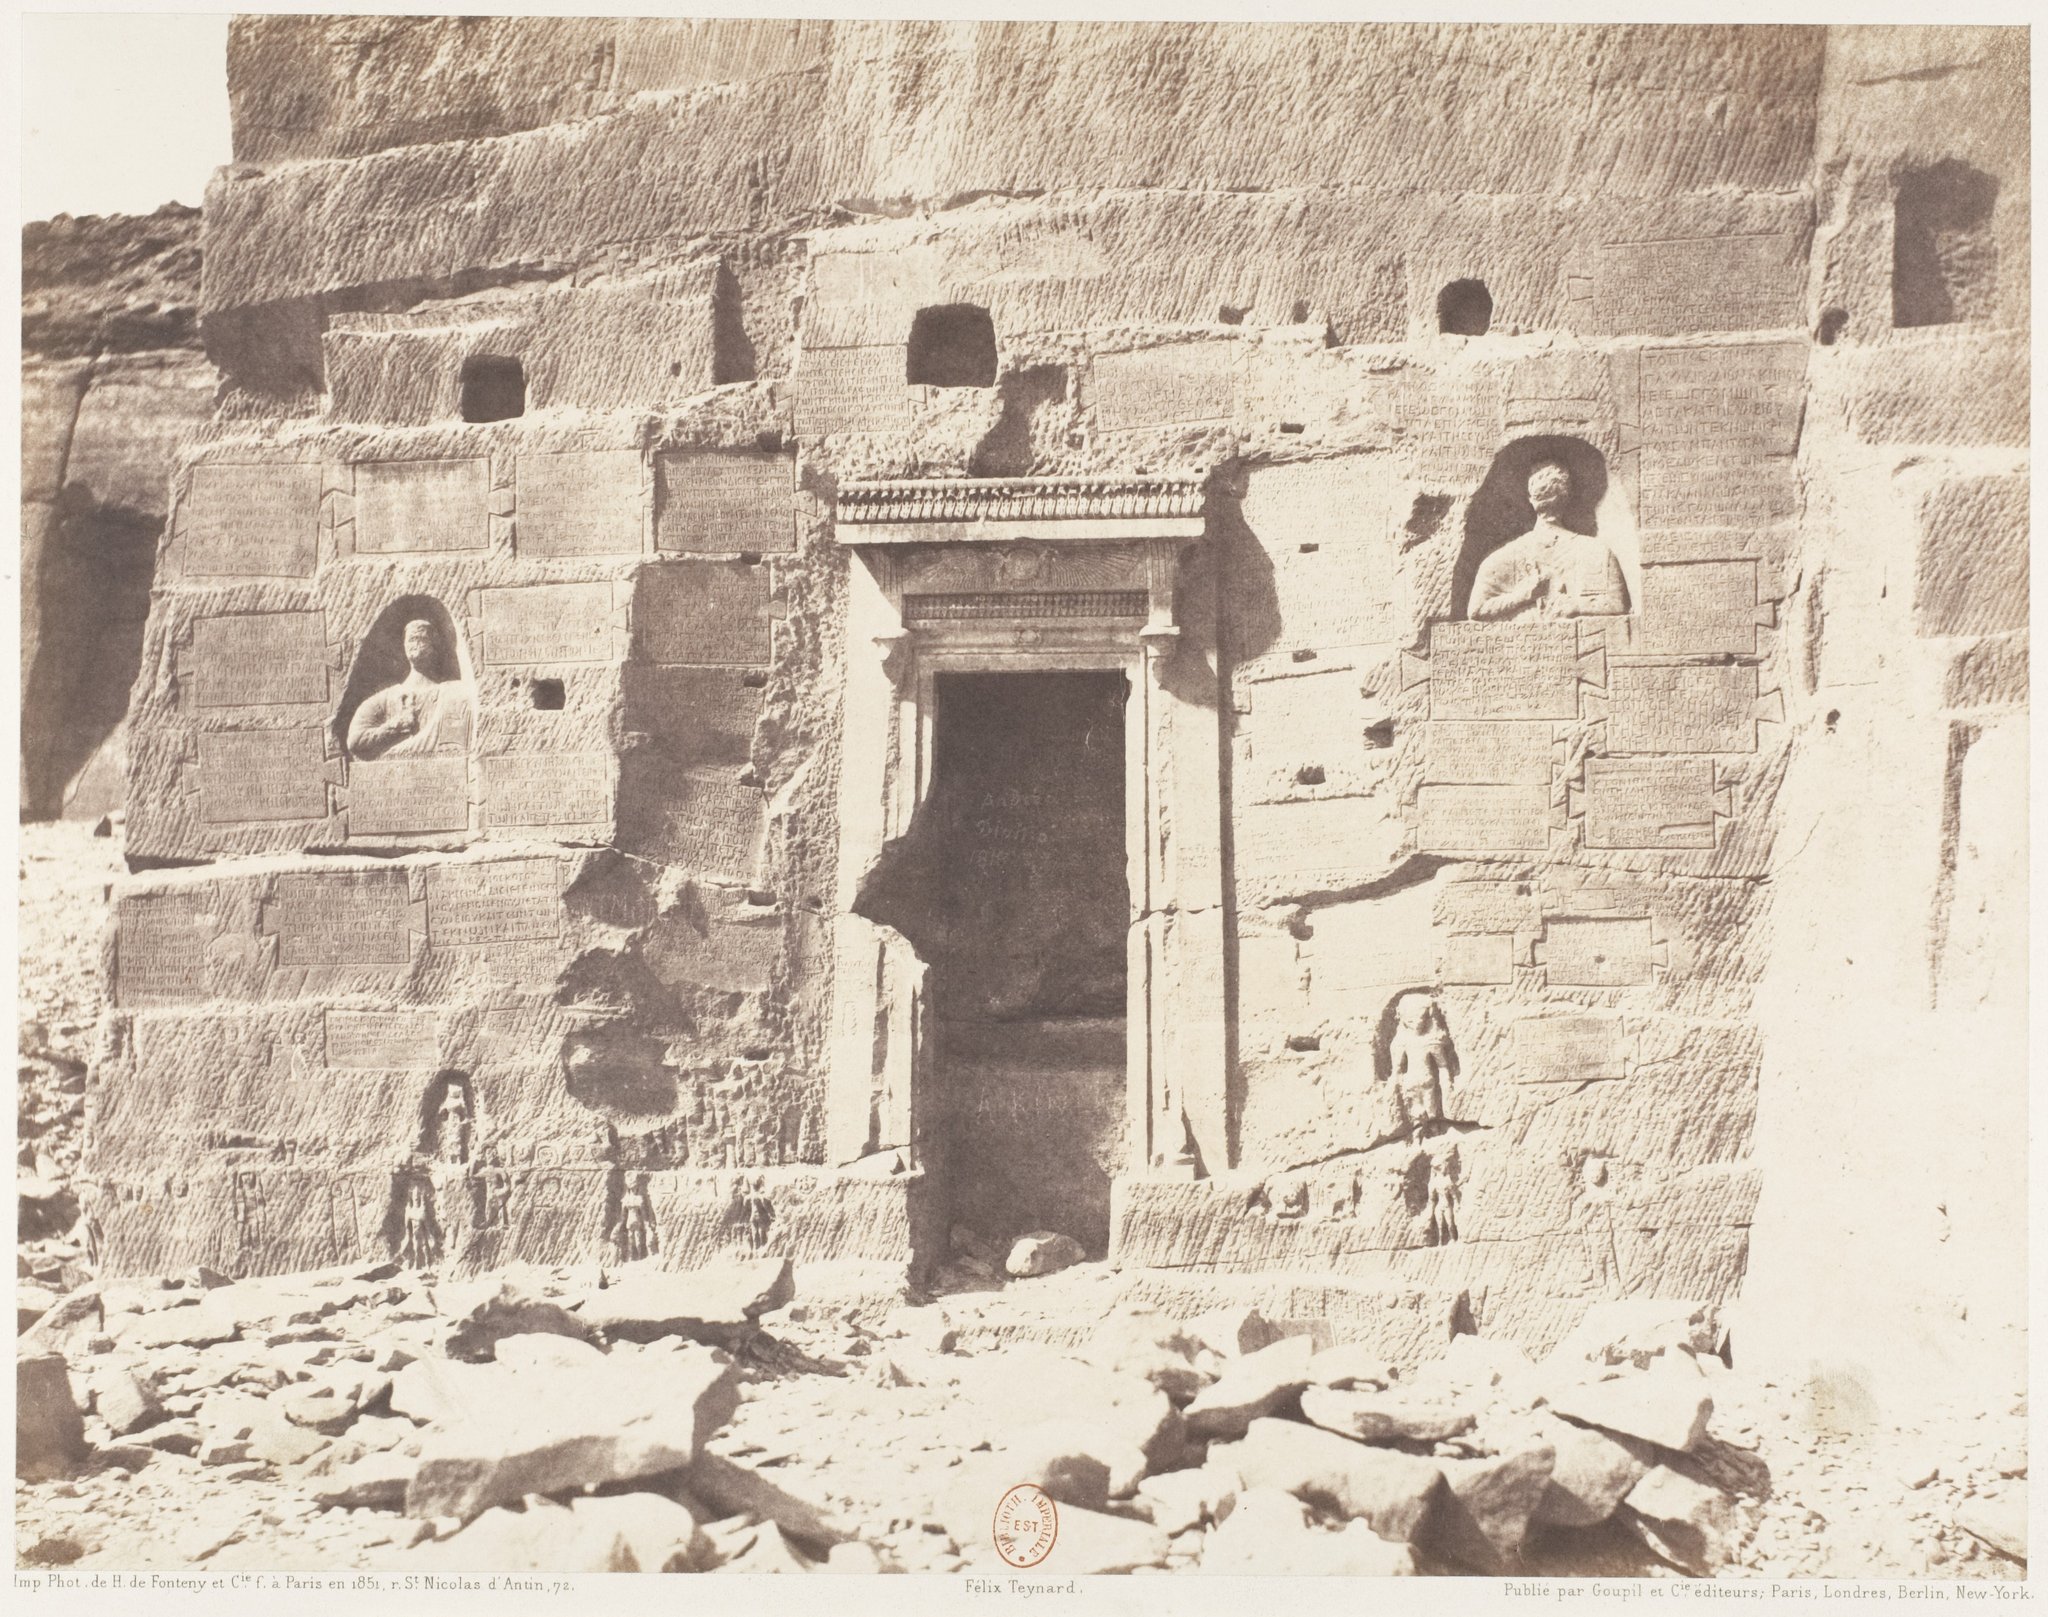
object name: photograph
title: Kardâcy, Sanctuaire, Niches et Inscriptions Taillées dans les Carrières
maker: félix teynard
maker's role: artist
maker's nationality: french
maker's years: 1817-1892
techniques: paper negative, salted paper print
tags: architecture,ruins